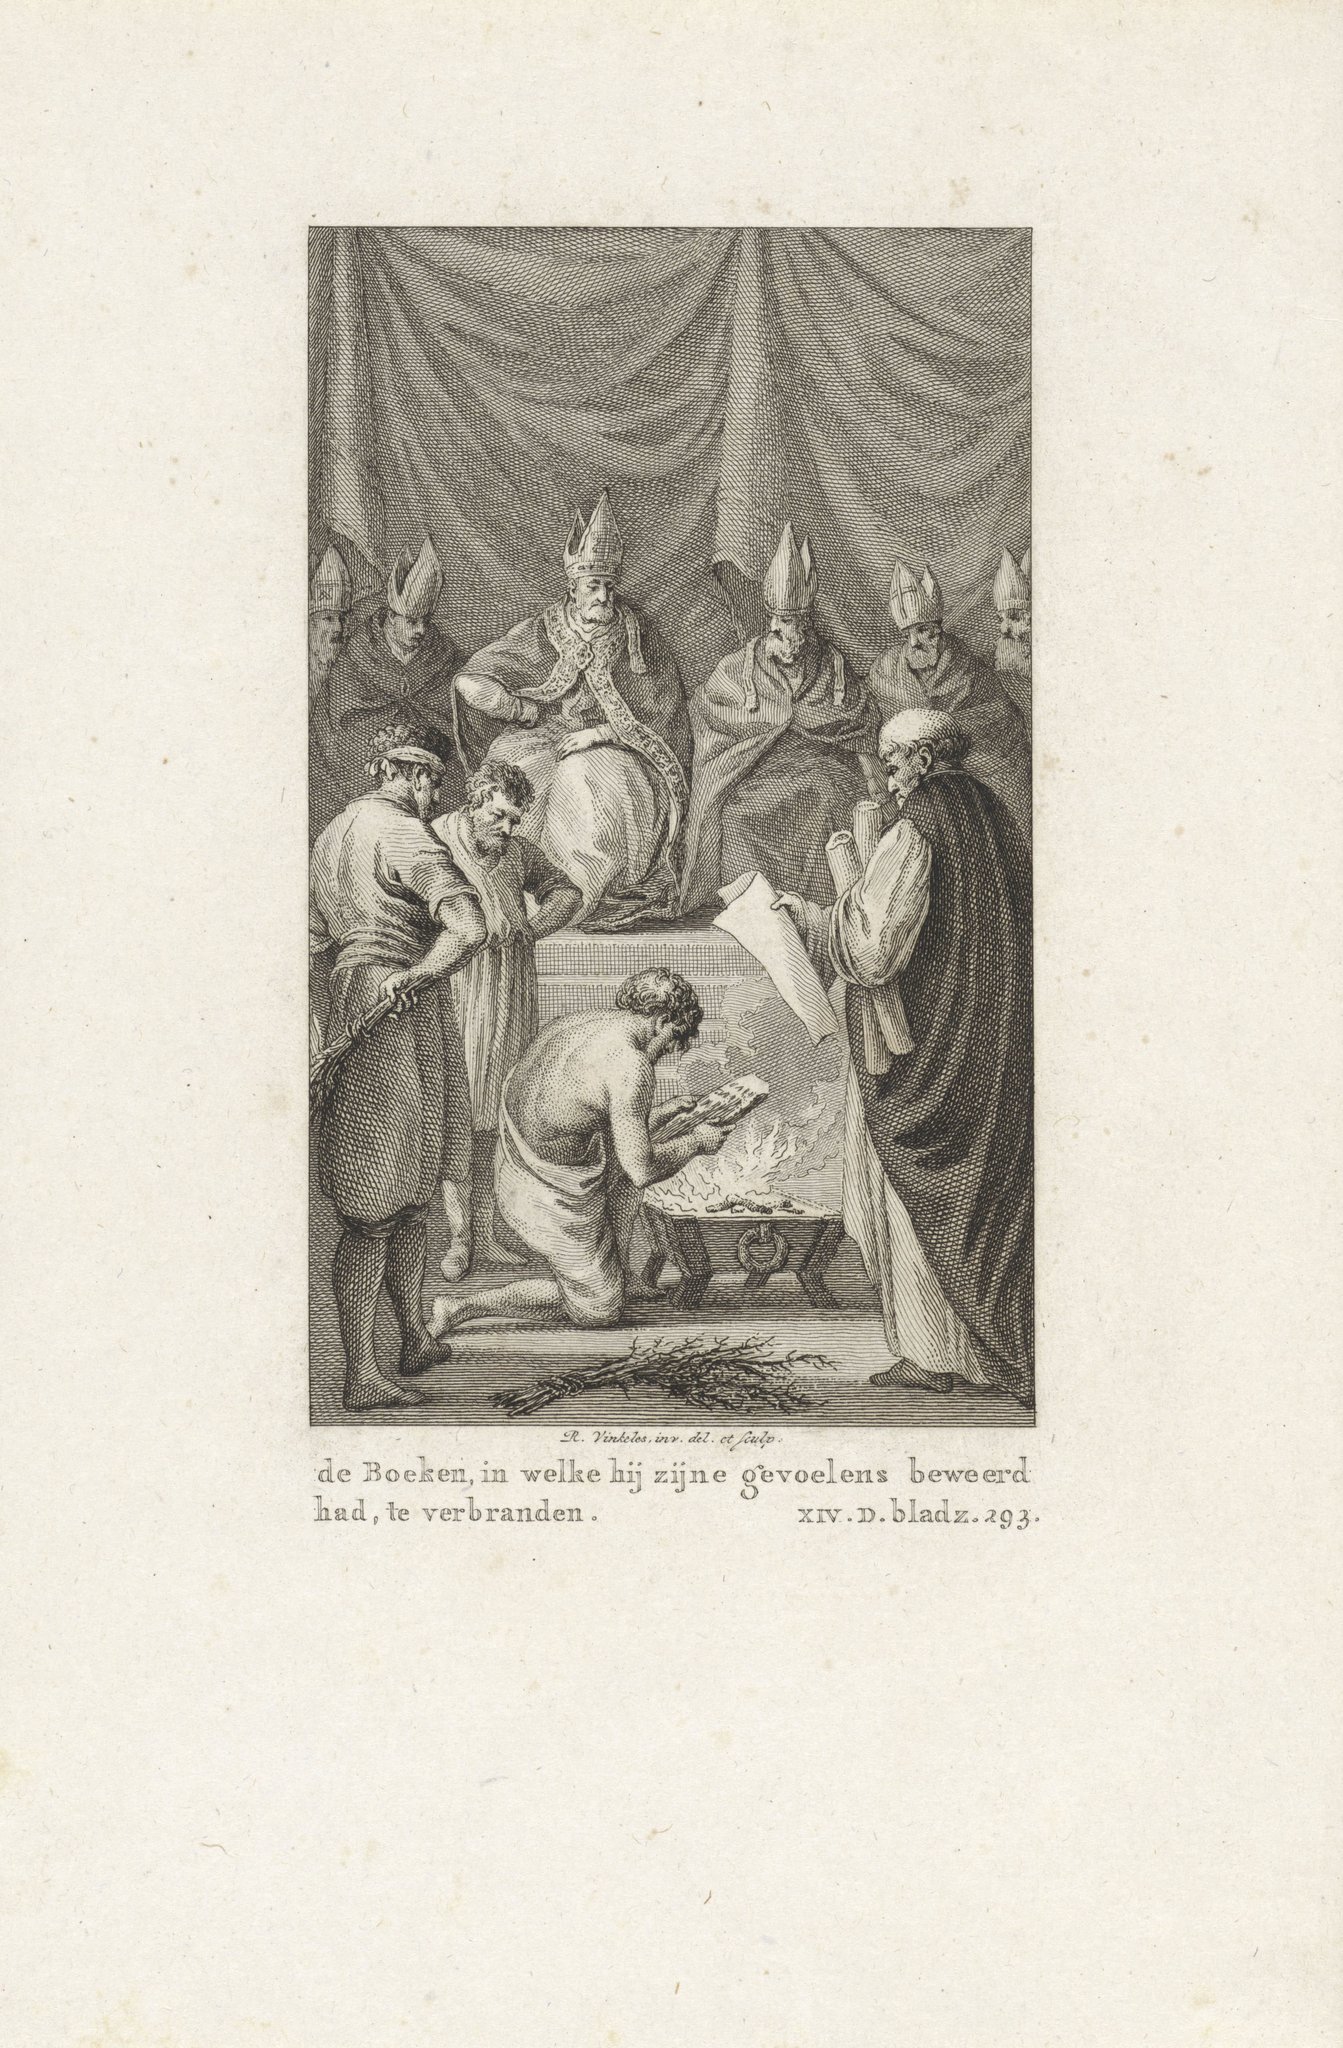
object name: book illustration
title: de Boeken, in welke hij zijne gevoelens beweerd had, te verbranden.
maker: reinier vinkeles (i)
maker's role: draughtsman, print maker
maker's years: 1741-1816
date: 1807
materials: paper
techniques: engraving, etching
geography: amsterdam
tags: archbishop, bishop, etc. (roman catholic), torture (+ judge), rod, birch ~ punishment at school, burning of books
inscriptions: collector's mark: Lugt 2228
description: Een deel van de twaalf bisschoppen kijkt toe hoe de door hen opgelegde straf door Godschalk wordt ondergaan. Godschalk verbrandt boeken nadat hij is afgeranseld met de roede.